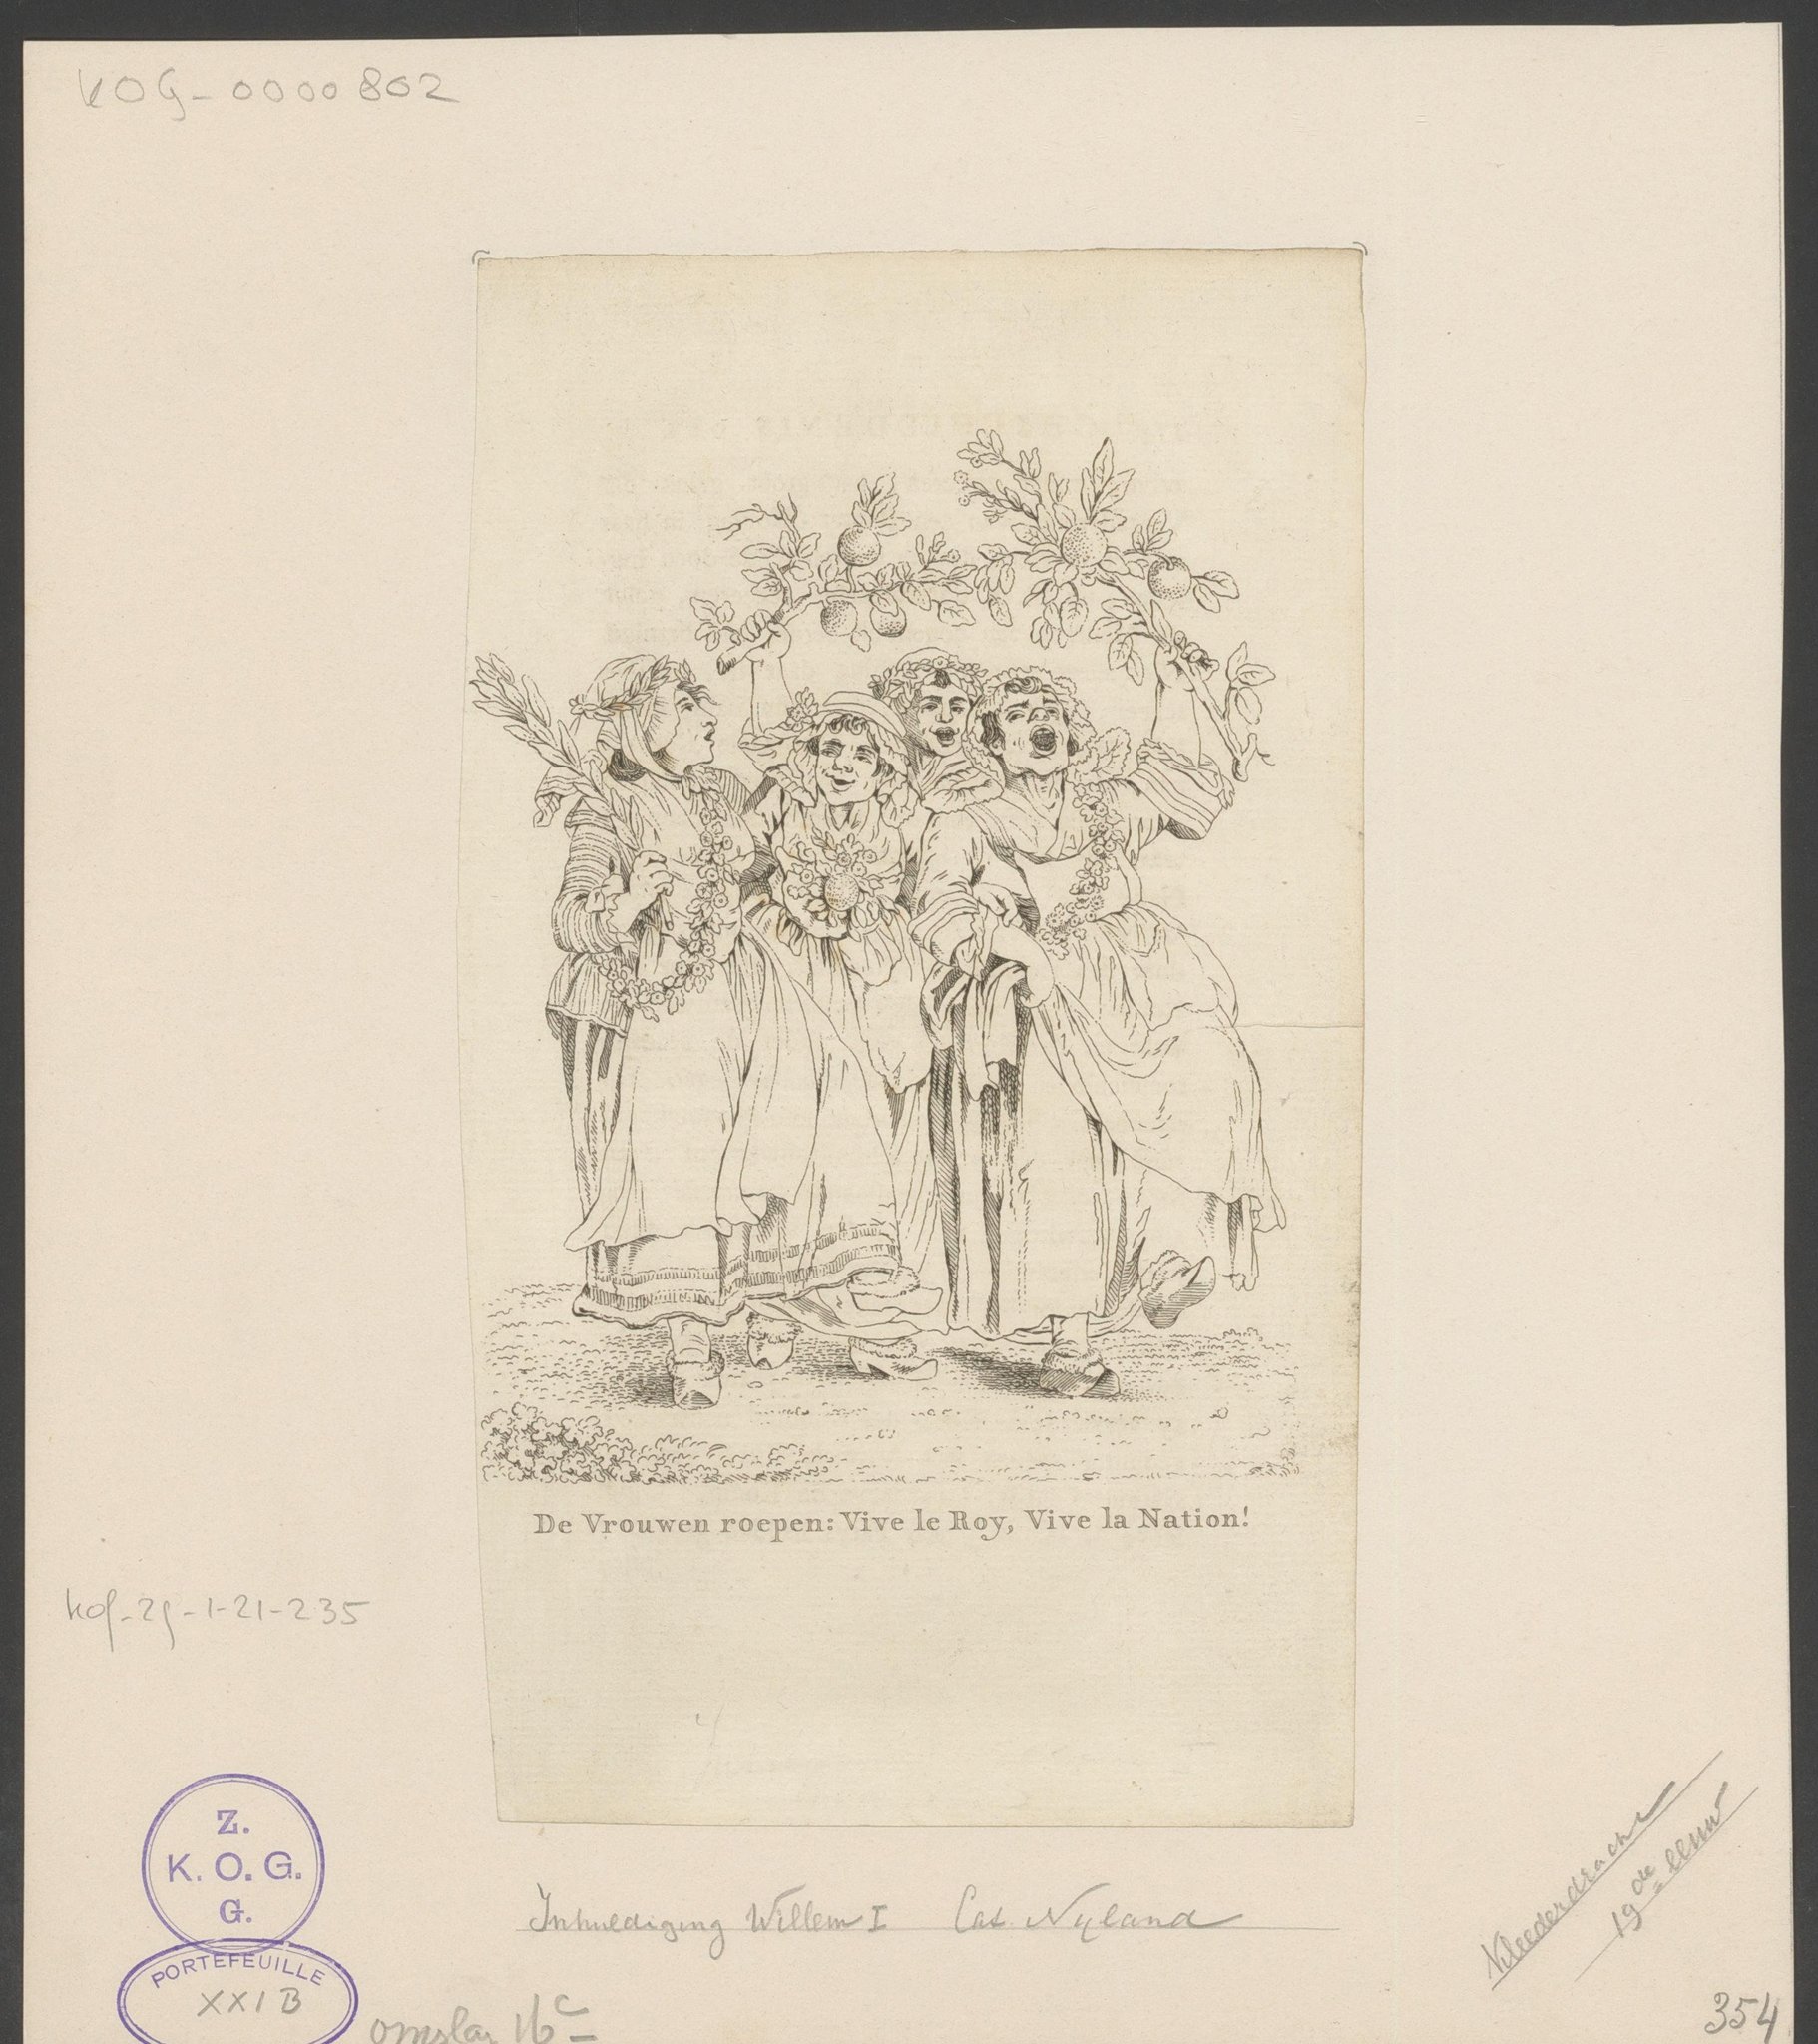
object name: print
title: De Vrouwen roepen: Vive le Roy, Vive la Nation!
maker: Anonymous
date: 1815-1830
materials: paper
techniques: etching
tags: the hague, berlin, william i of the netherlands, dancing, female singer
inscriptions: collector's mark: Lugt 1641, stamp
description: Onderwerpsrubrieken binnen de Atlas Zeden en Gewoonten: Zeden en Gewoonten in Engeren Zin, De Kleeding, Kleederdrachten (tijdvakken), Het begin der 19de eeuw. Mannen en vrouwen.